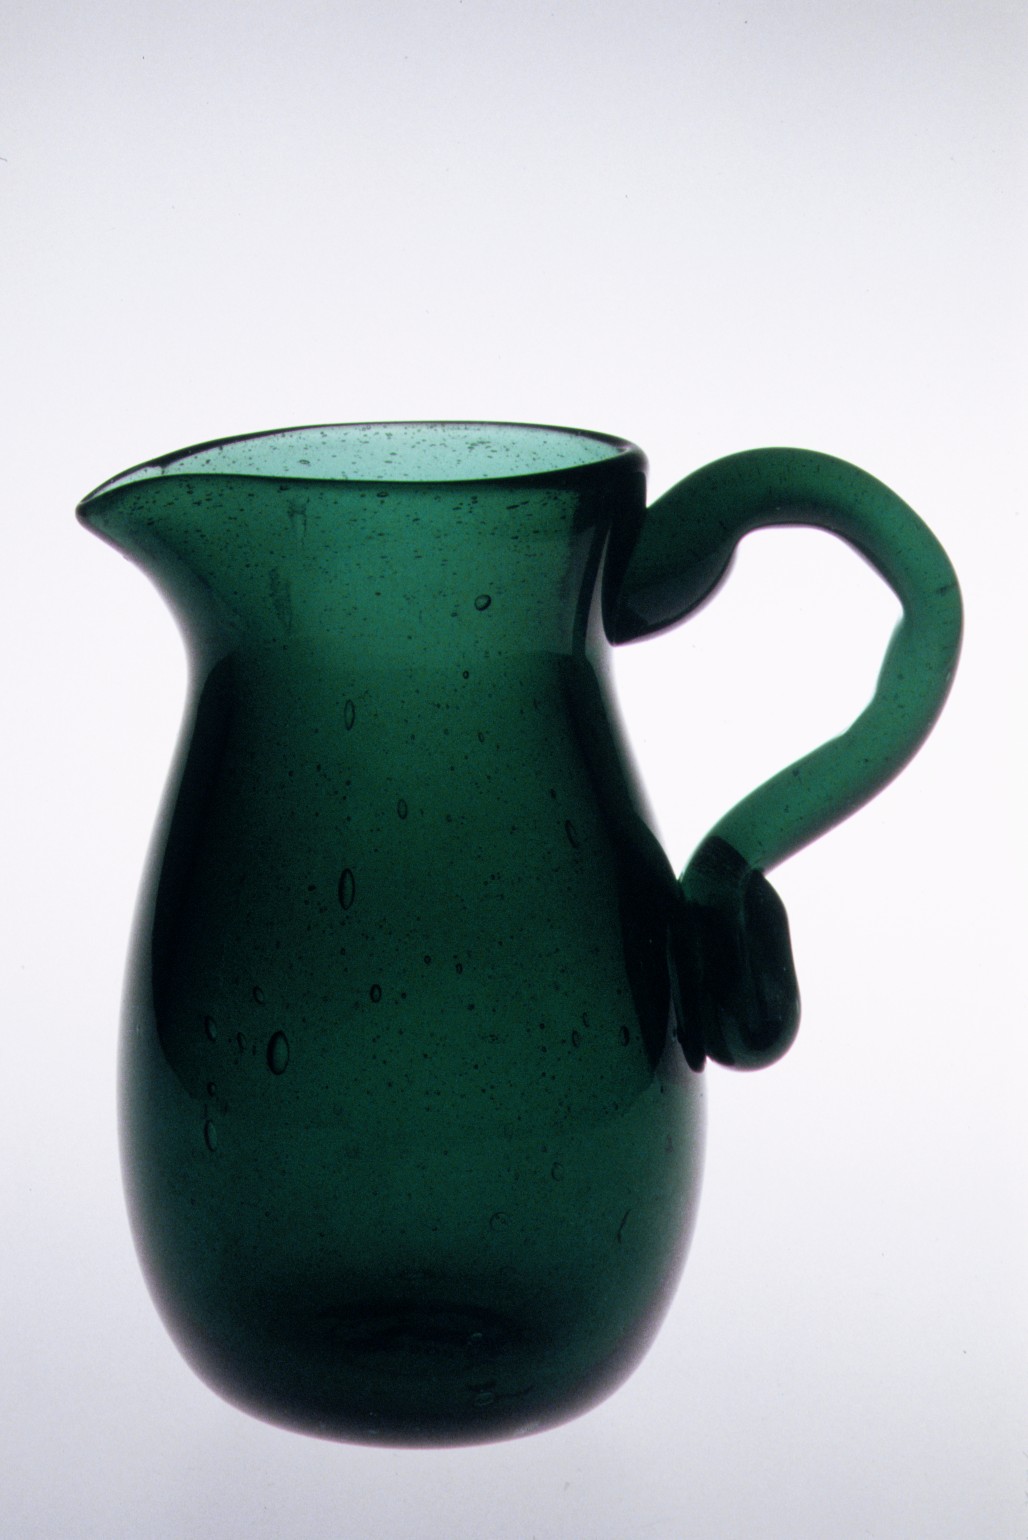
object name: pitcher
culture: american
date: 1825-1875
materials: glass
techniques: glassblowing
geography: united states